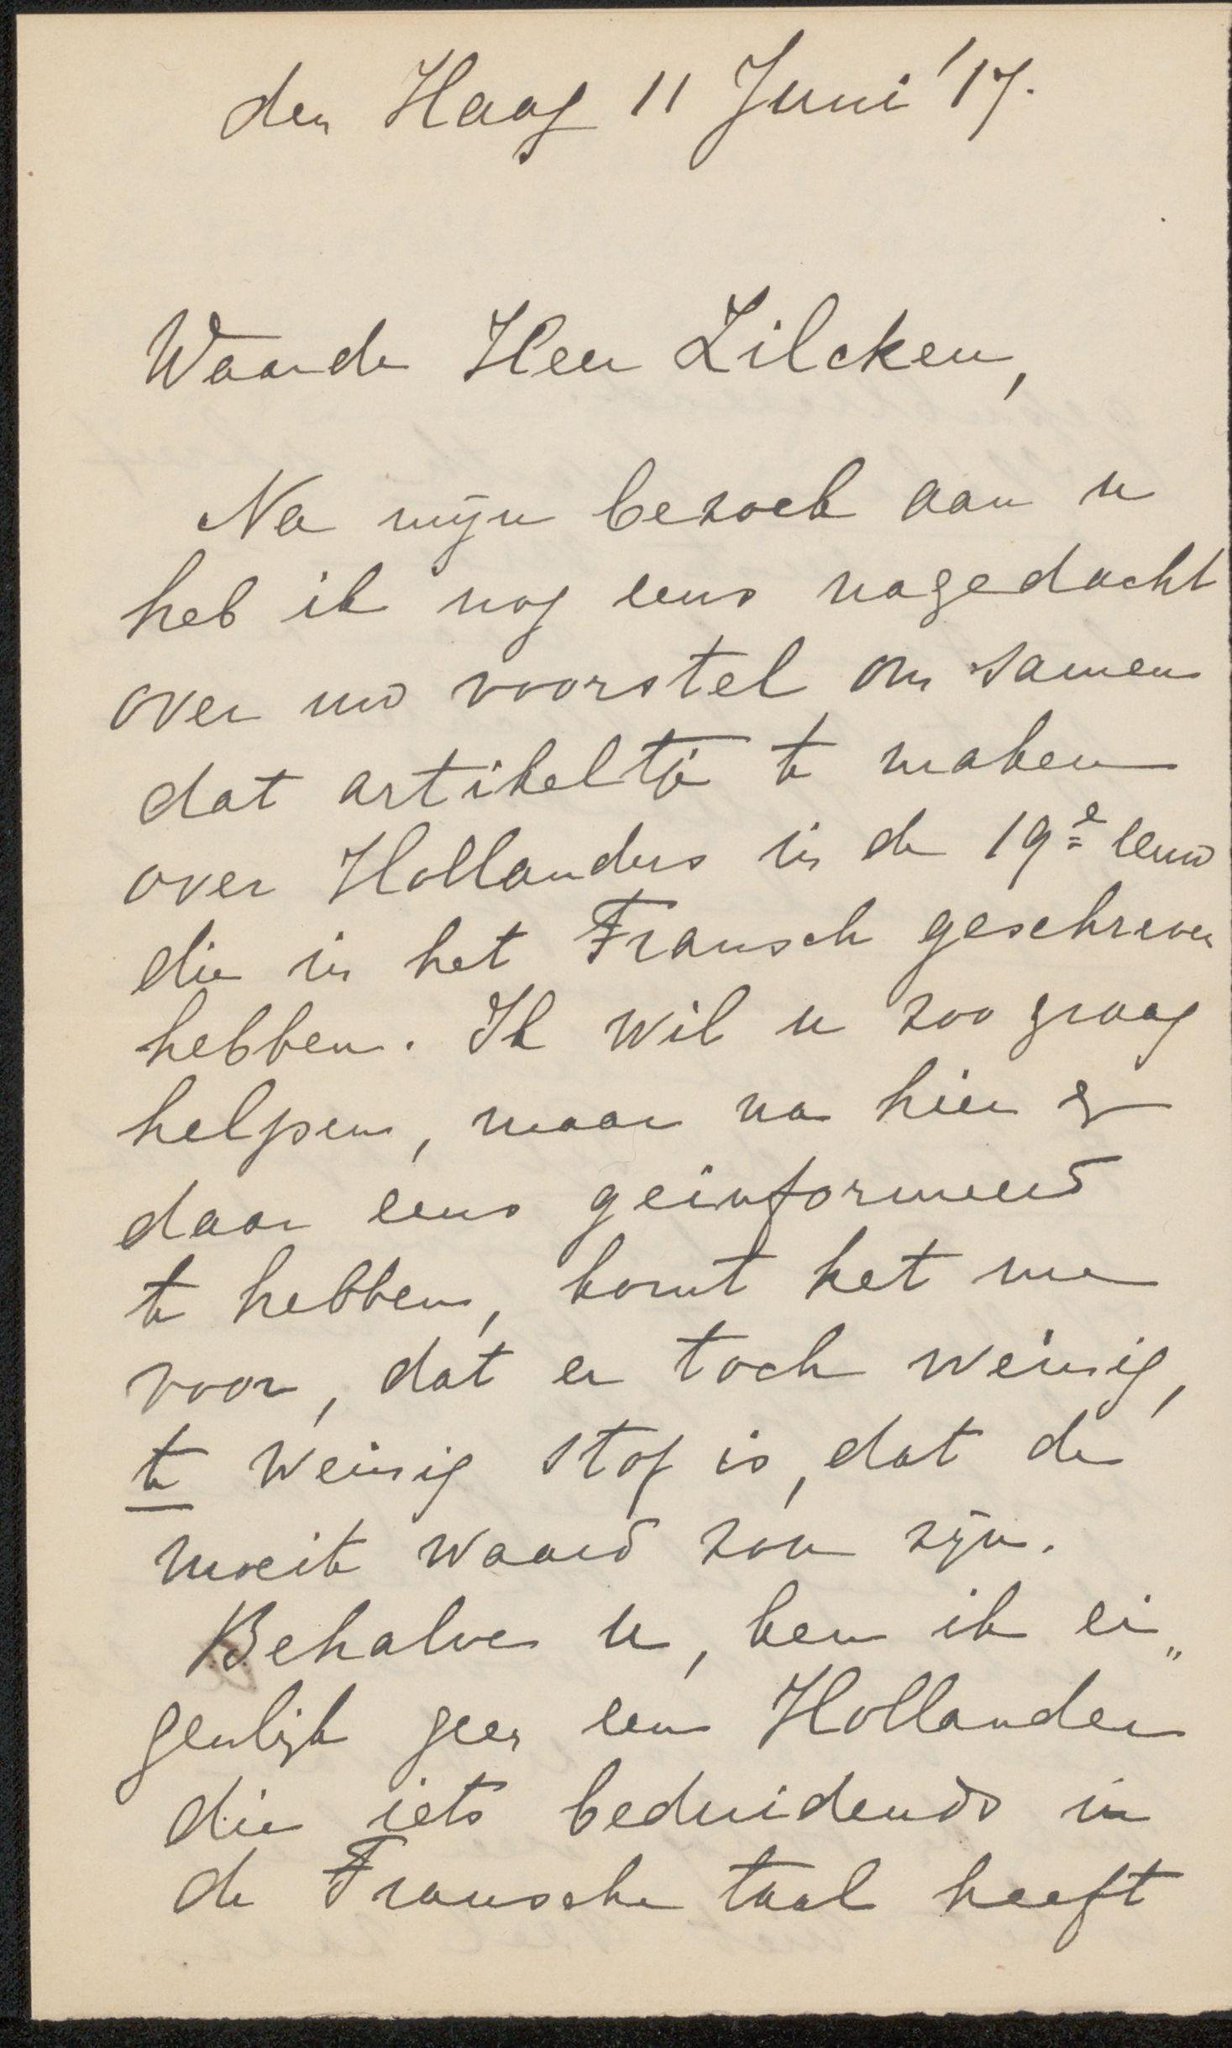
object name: invitation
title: Uitnodiging aan Philip Zilcken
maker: fenna de meyier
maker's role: onderwijzer, schrijver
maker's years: 1874-1943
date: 1917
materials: ink, paper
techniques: pen, printing, writing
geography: the hague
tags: amsterdam, hélène swarth, painter, draughtsman, philip zilcken, the graphic arts, workshop, studio of the artist (in general), printed matter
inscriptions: collector's mark: ‘RPK’